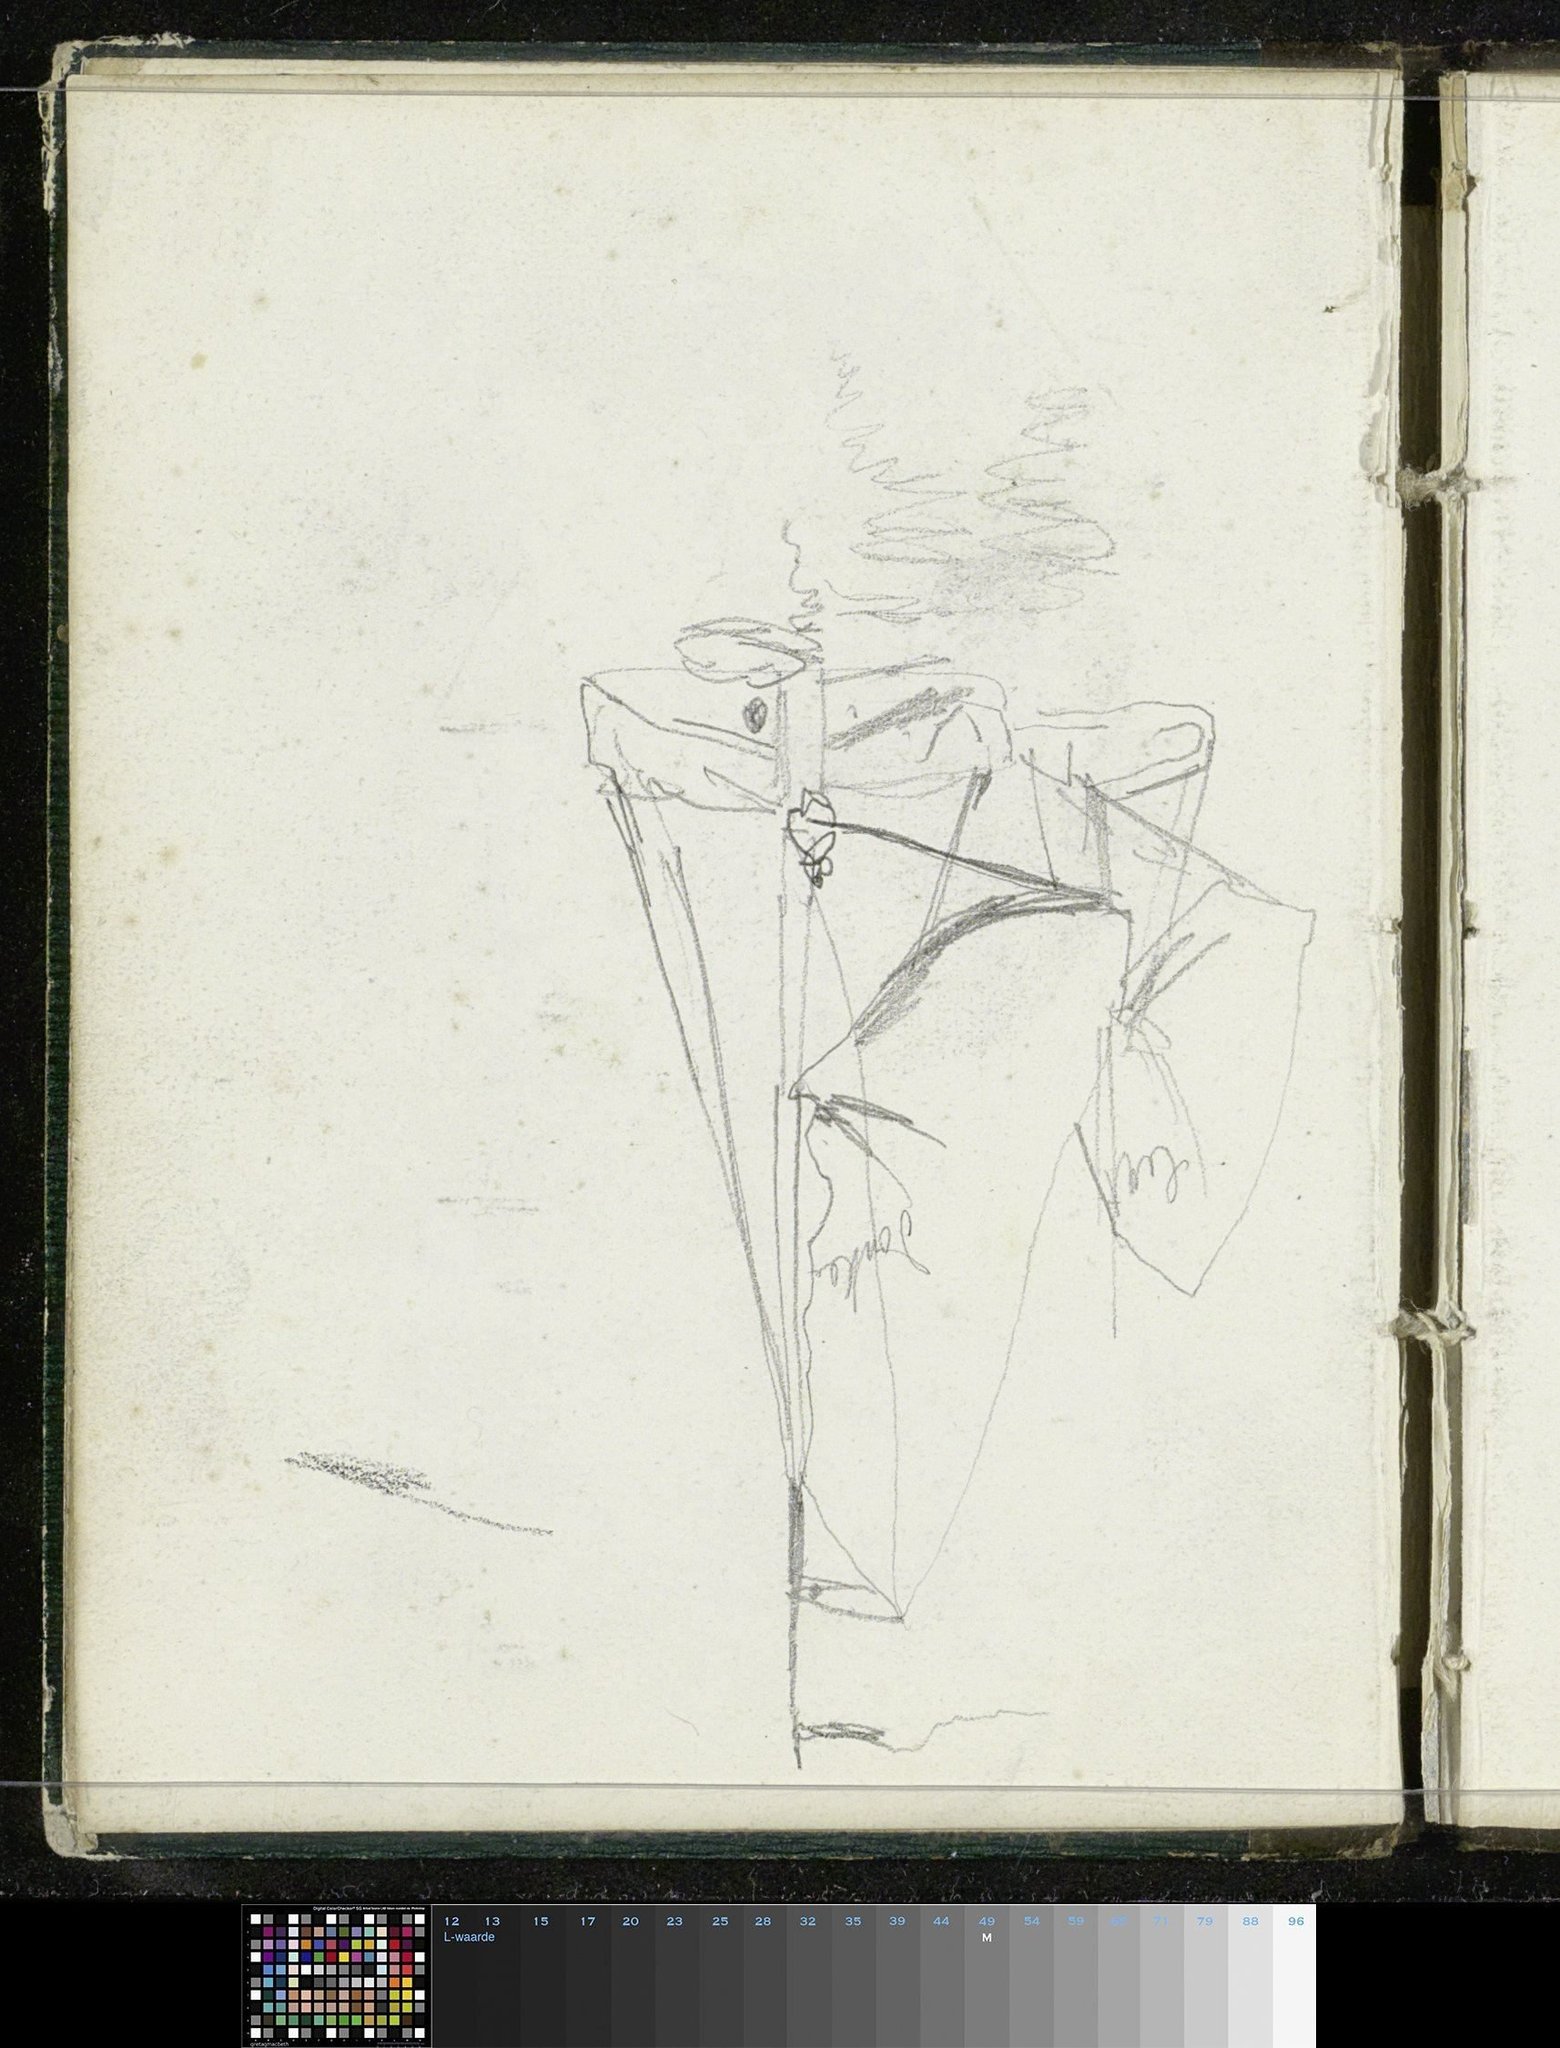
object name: sketchbook leaf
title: Twee zeilboten op het water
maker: johan hendrik weissenbruch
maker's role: draughtsman, painter, print maker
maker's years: 1824-1903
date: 1834-1903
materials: paper, pencil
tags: sailing-ship, sailing-boat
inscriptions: kleurnotitie, handgeschreven in potlood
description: Blad 3 verso uit een schetsboek met 34 bladen.